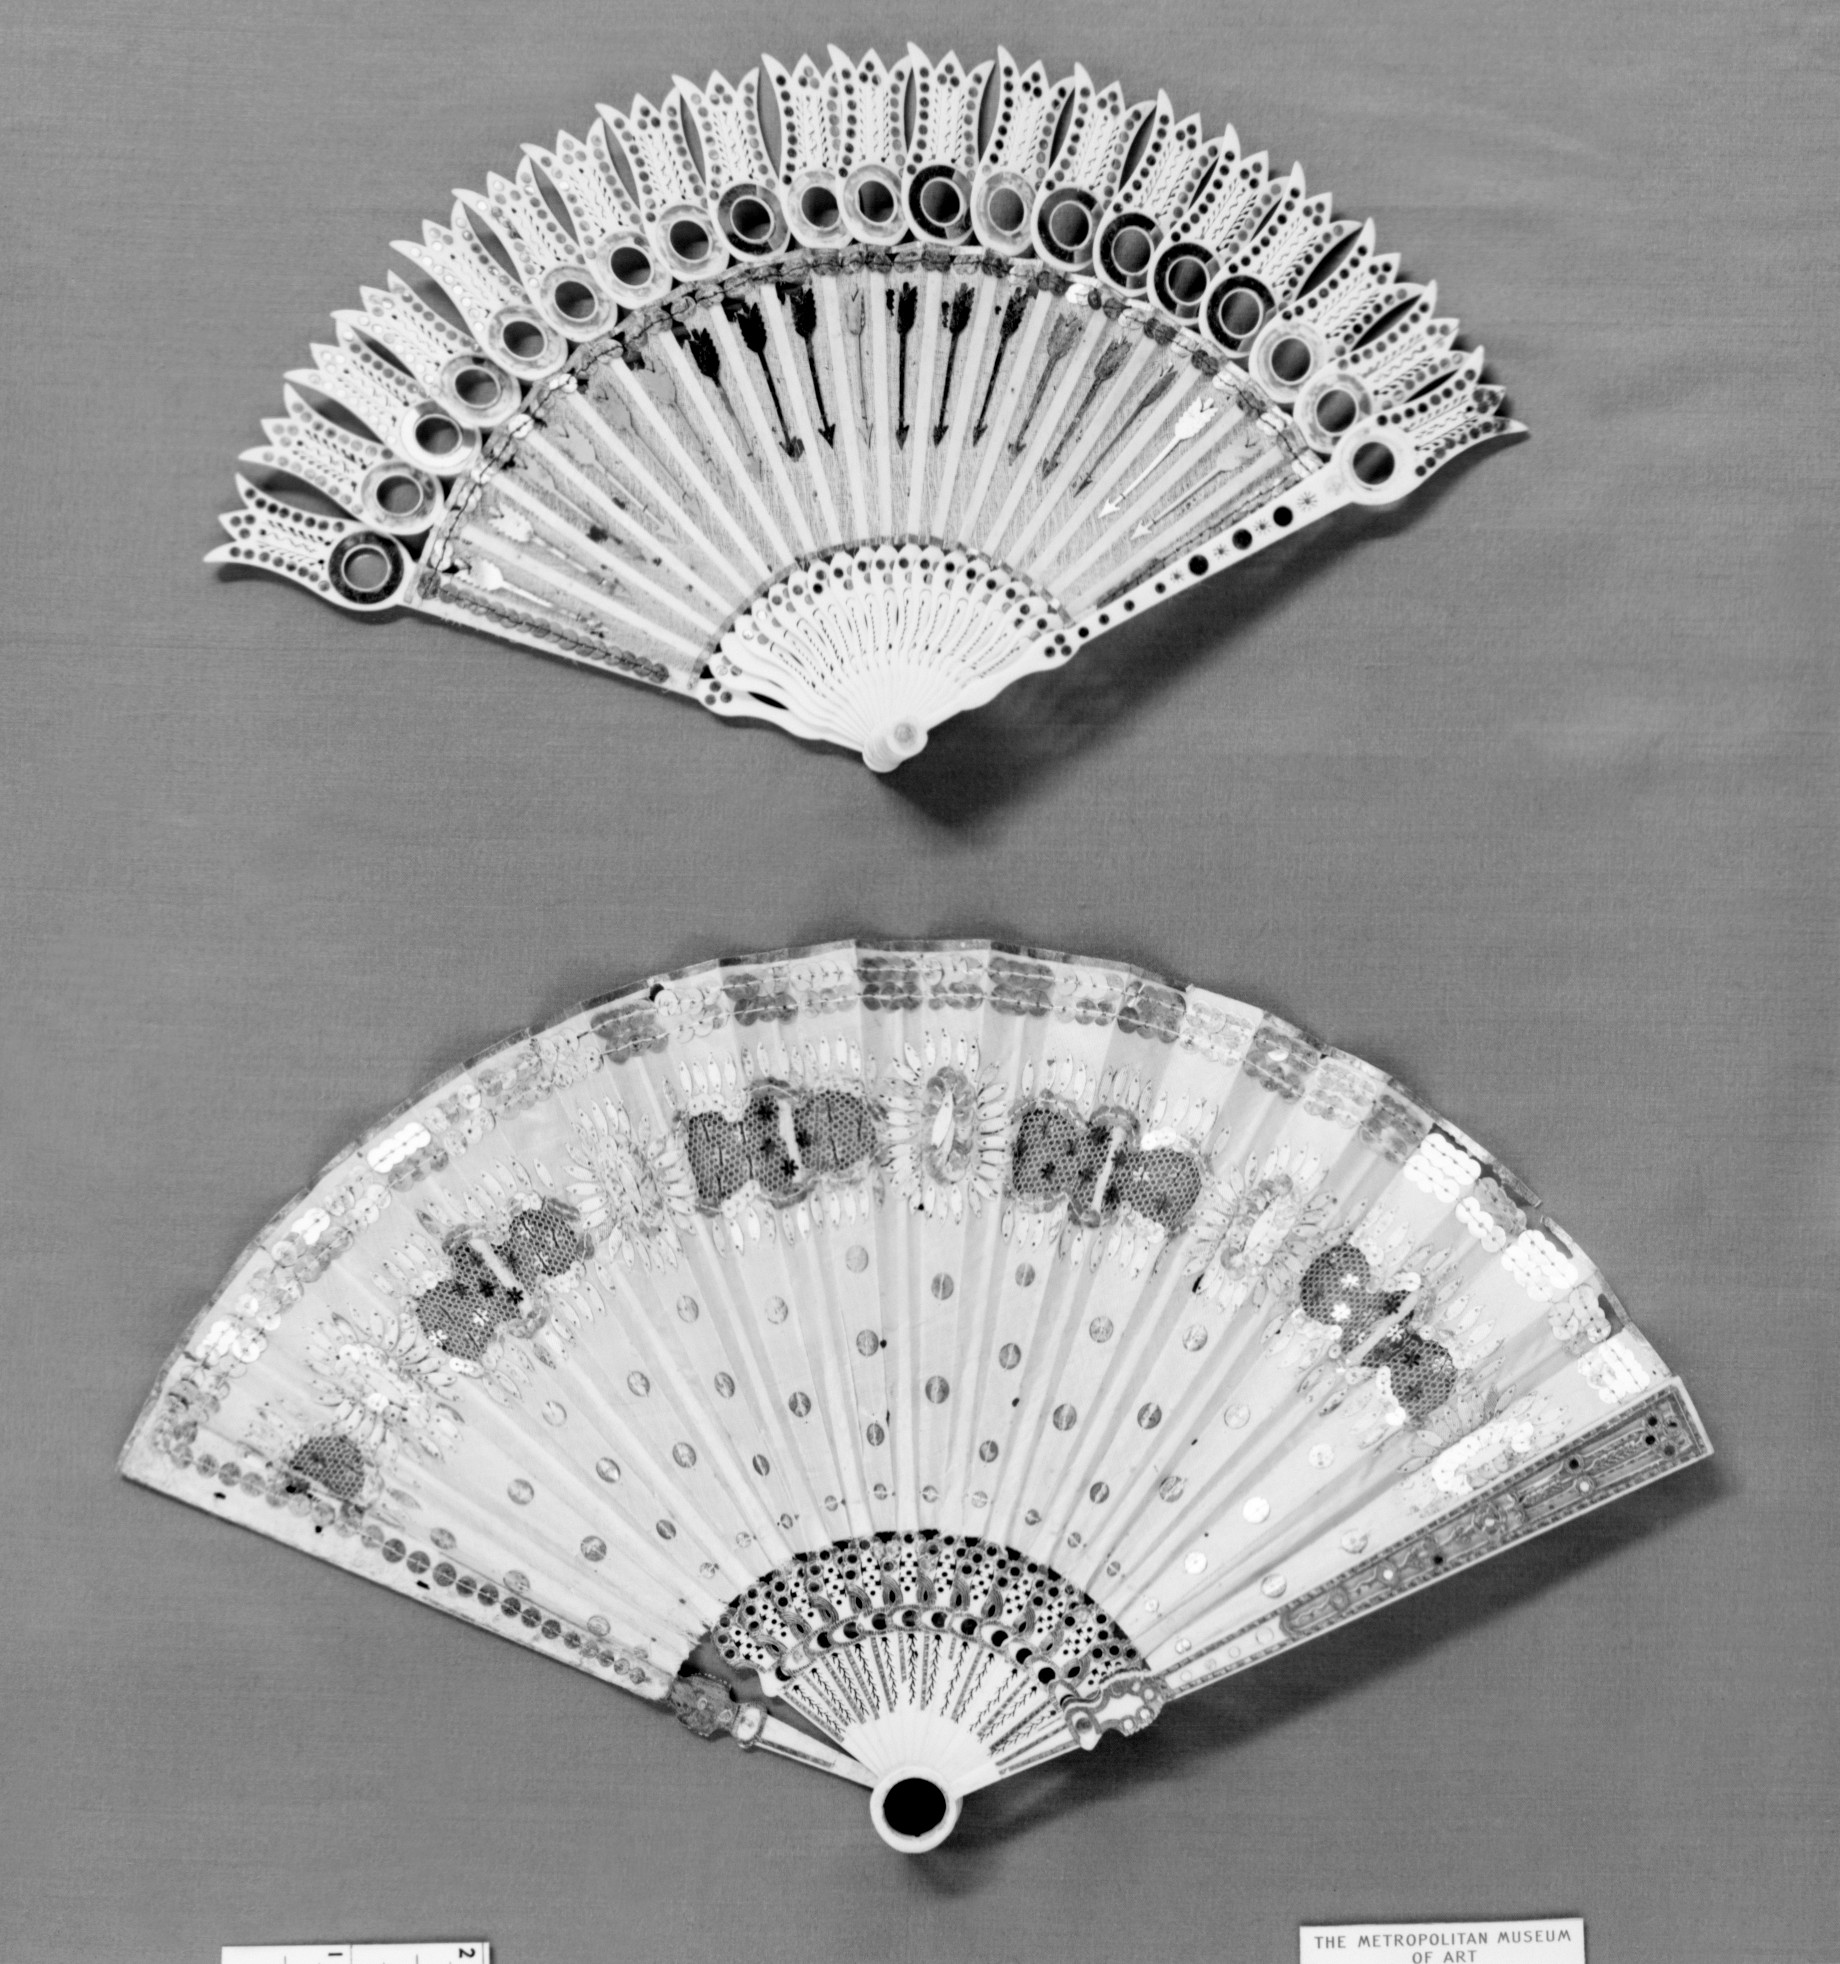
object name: fan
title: Lorgnette Fan with Love's Arrows motif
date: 1790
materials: ivory, mica